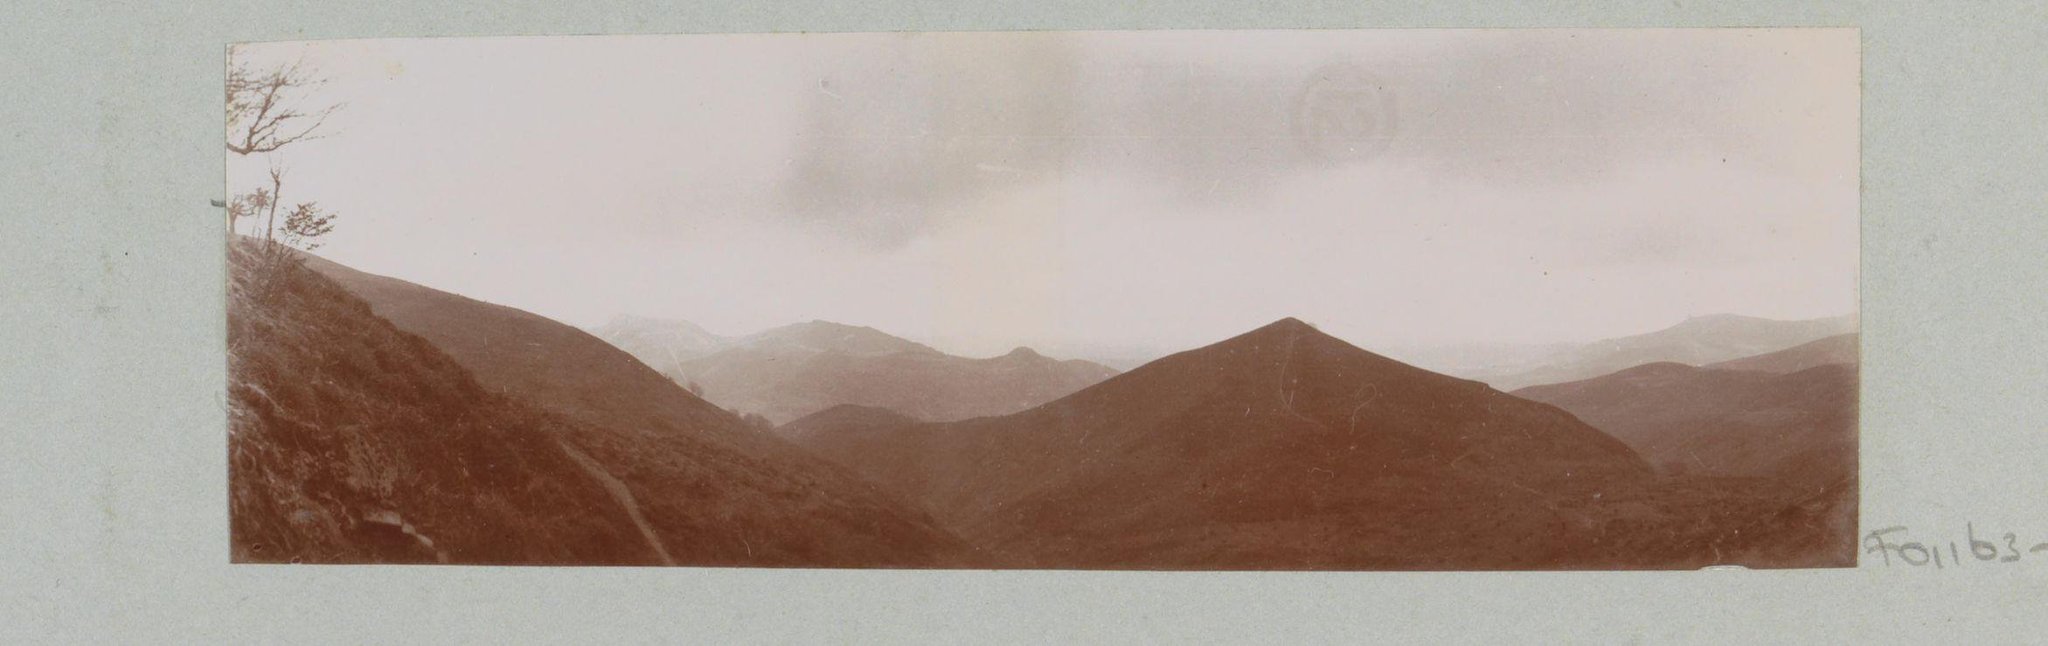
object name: photograph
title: Berglandschap, vermoedelijk in de Pyreneeën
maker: delizy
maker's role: manufacturer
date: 1904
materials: paper, photographic support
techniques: gelatin silver print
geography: pyrenees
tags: mountain-top, peak (+ landscape with figures, staffage), mountains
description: Onderdeel van Fotoalbum van een Franse amateurfotograaf met opnames van uitstapjes in Frankrijk, Spanje, België, Luxemburg en Nederland, de eerste automobielen en autoraces.